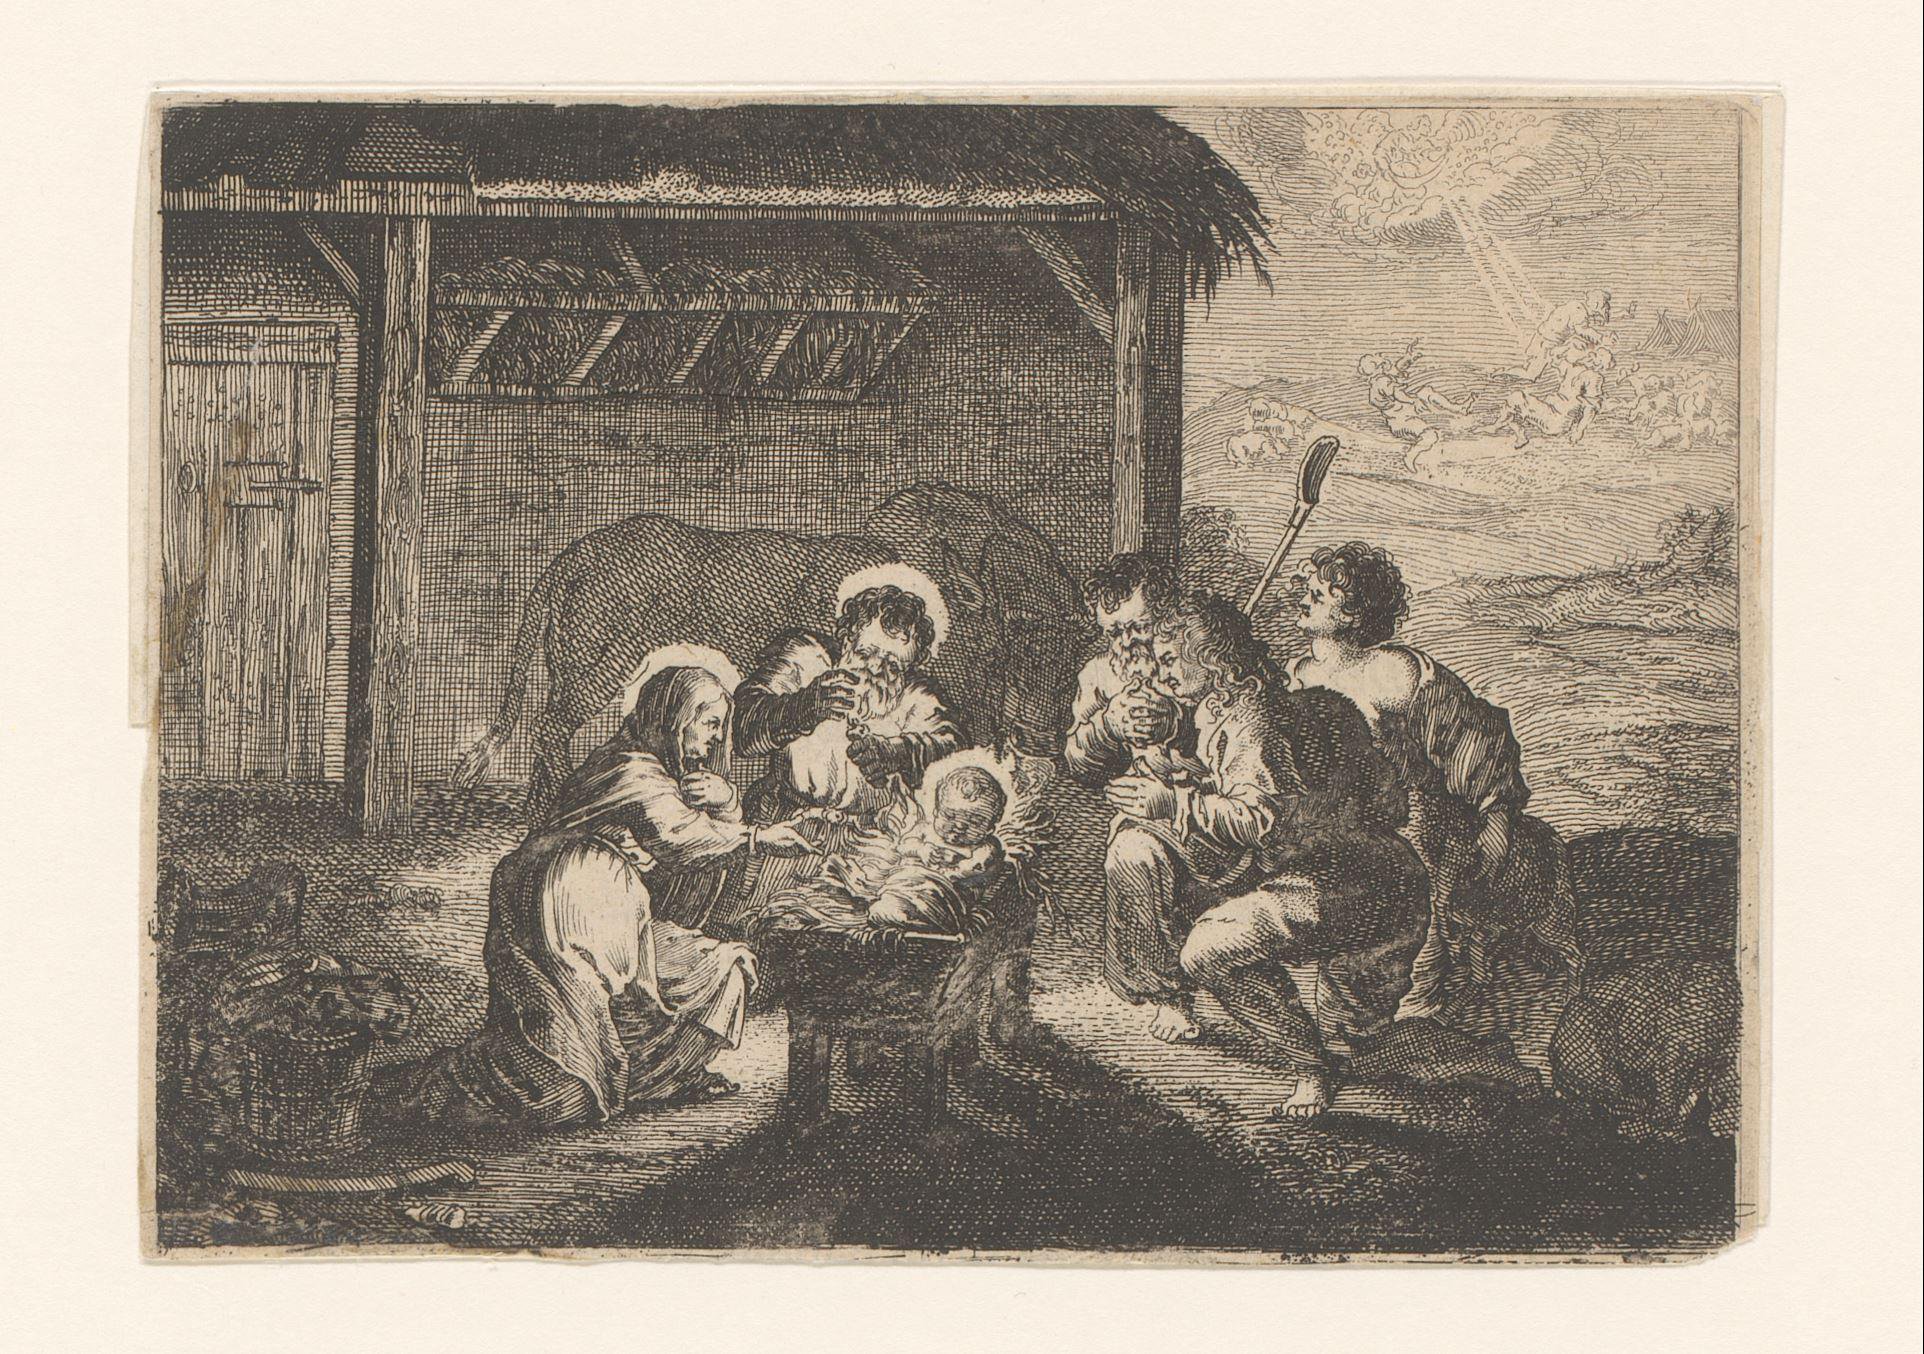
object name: print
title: Sr. Francoÿse Clare van S. Lieven Penitente Recollectine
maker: Anonymous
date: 1600-1699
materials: paper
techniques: engraving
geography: netherlands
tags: female saints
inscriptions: collector's mark: Lugt 2228